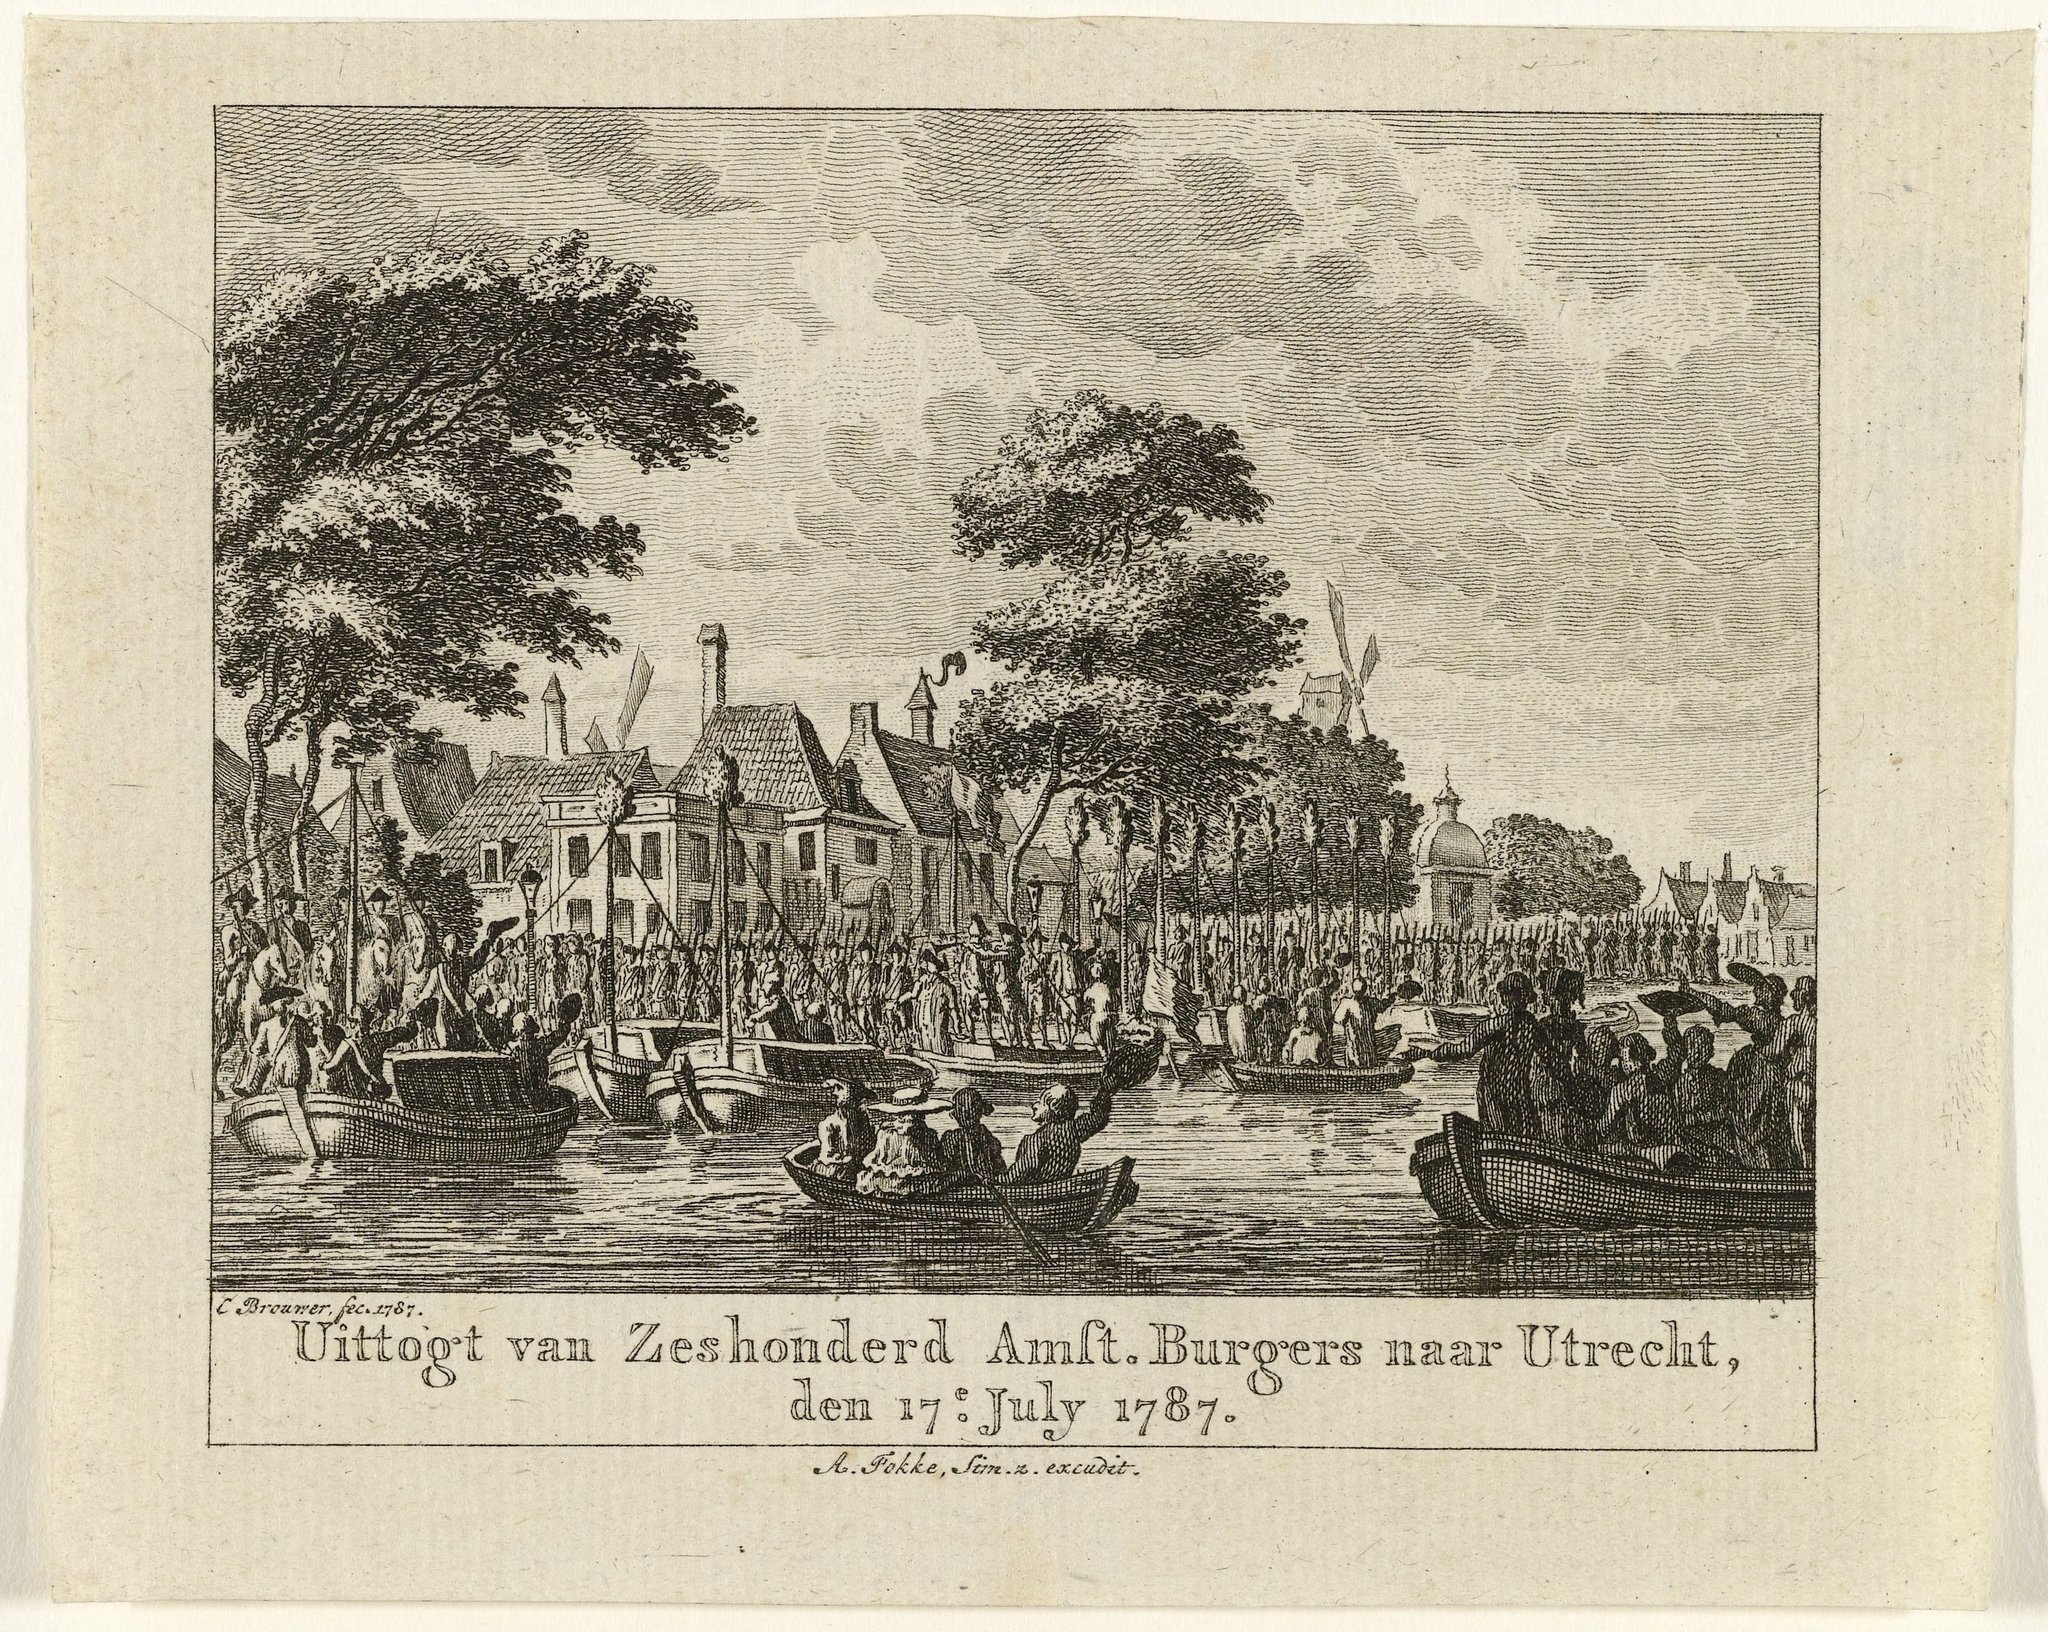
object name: print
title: Uittogt van Zeshonderd Amst. Burgers naar Utrecht, den 17e July 1787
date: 1787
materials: paper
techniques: etching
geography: amsterdam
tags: waving farewell ~ departure on a journey (+ propulsion of vehicle, ship, etc. by ...)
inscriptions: collector's mark: Lugt 2228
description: Gezicht op de herberg Berebijt aan de Amstel van waar schuiten met de 600 gewapende Amsterdamse burgers inschepen en vertrekken naar Utrecht, 17 juli 1787.